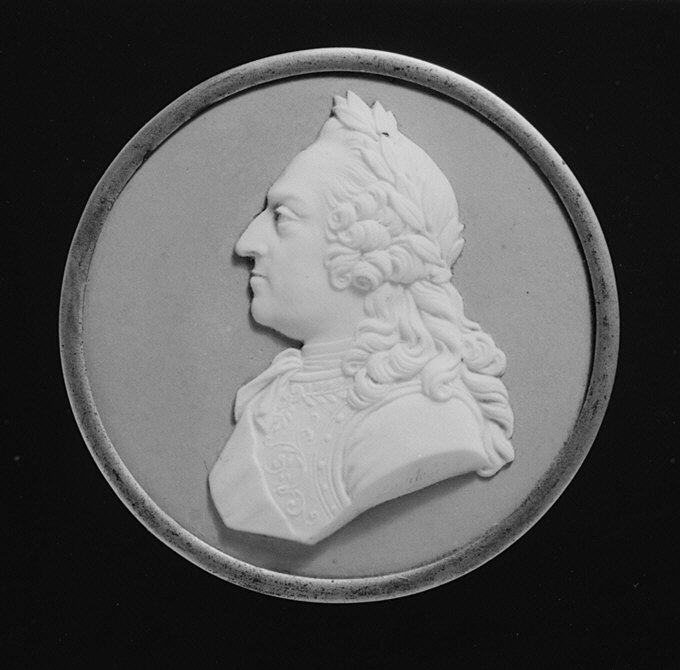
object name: medallion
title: Louis XV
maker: sèvres manufactory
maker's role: manufactory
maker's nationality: french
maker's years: 1740-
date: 1818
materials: biscuit, paste, porcelain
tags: men,profiles